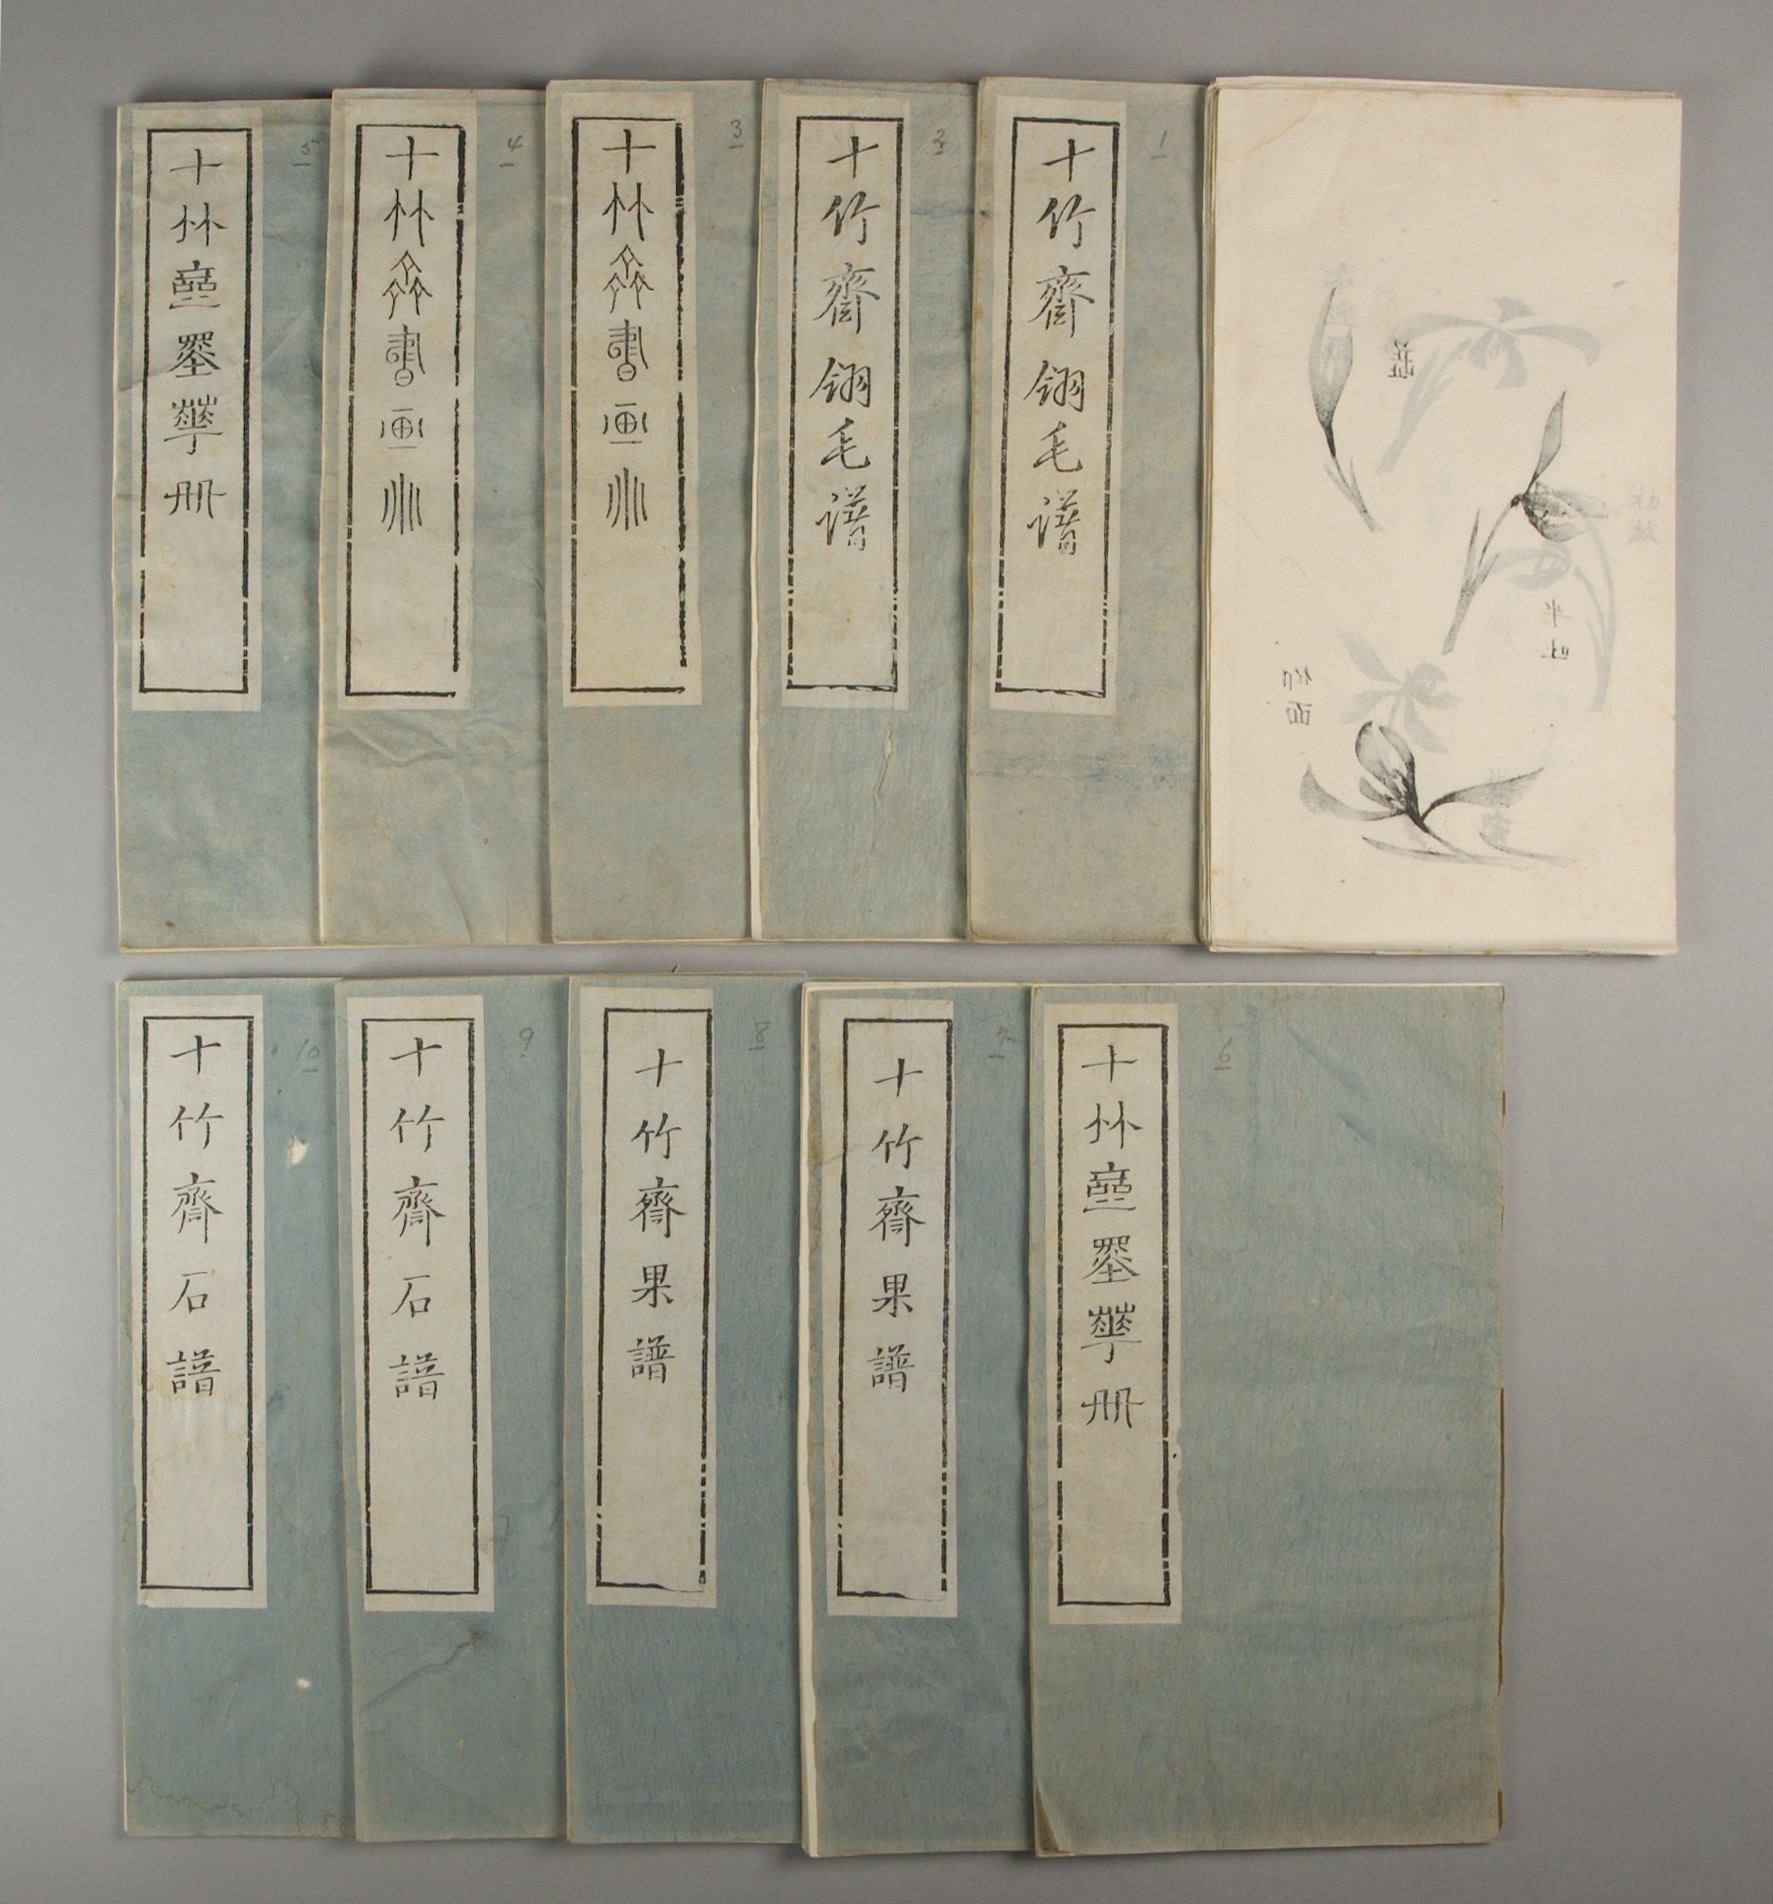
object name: illustrated book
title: Ten Bamboo Studio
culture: chinese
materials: ink, paper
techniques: woodblock print